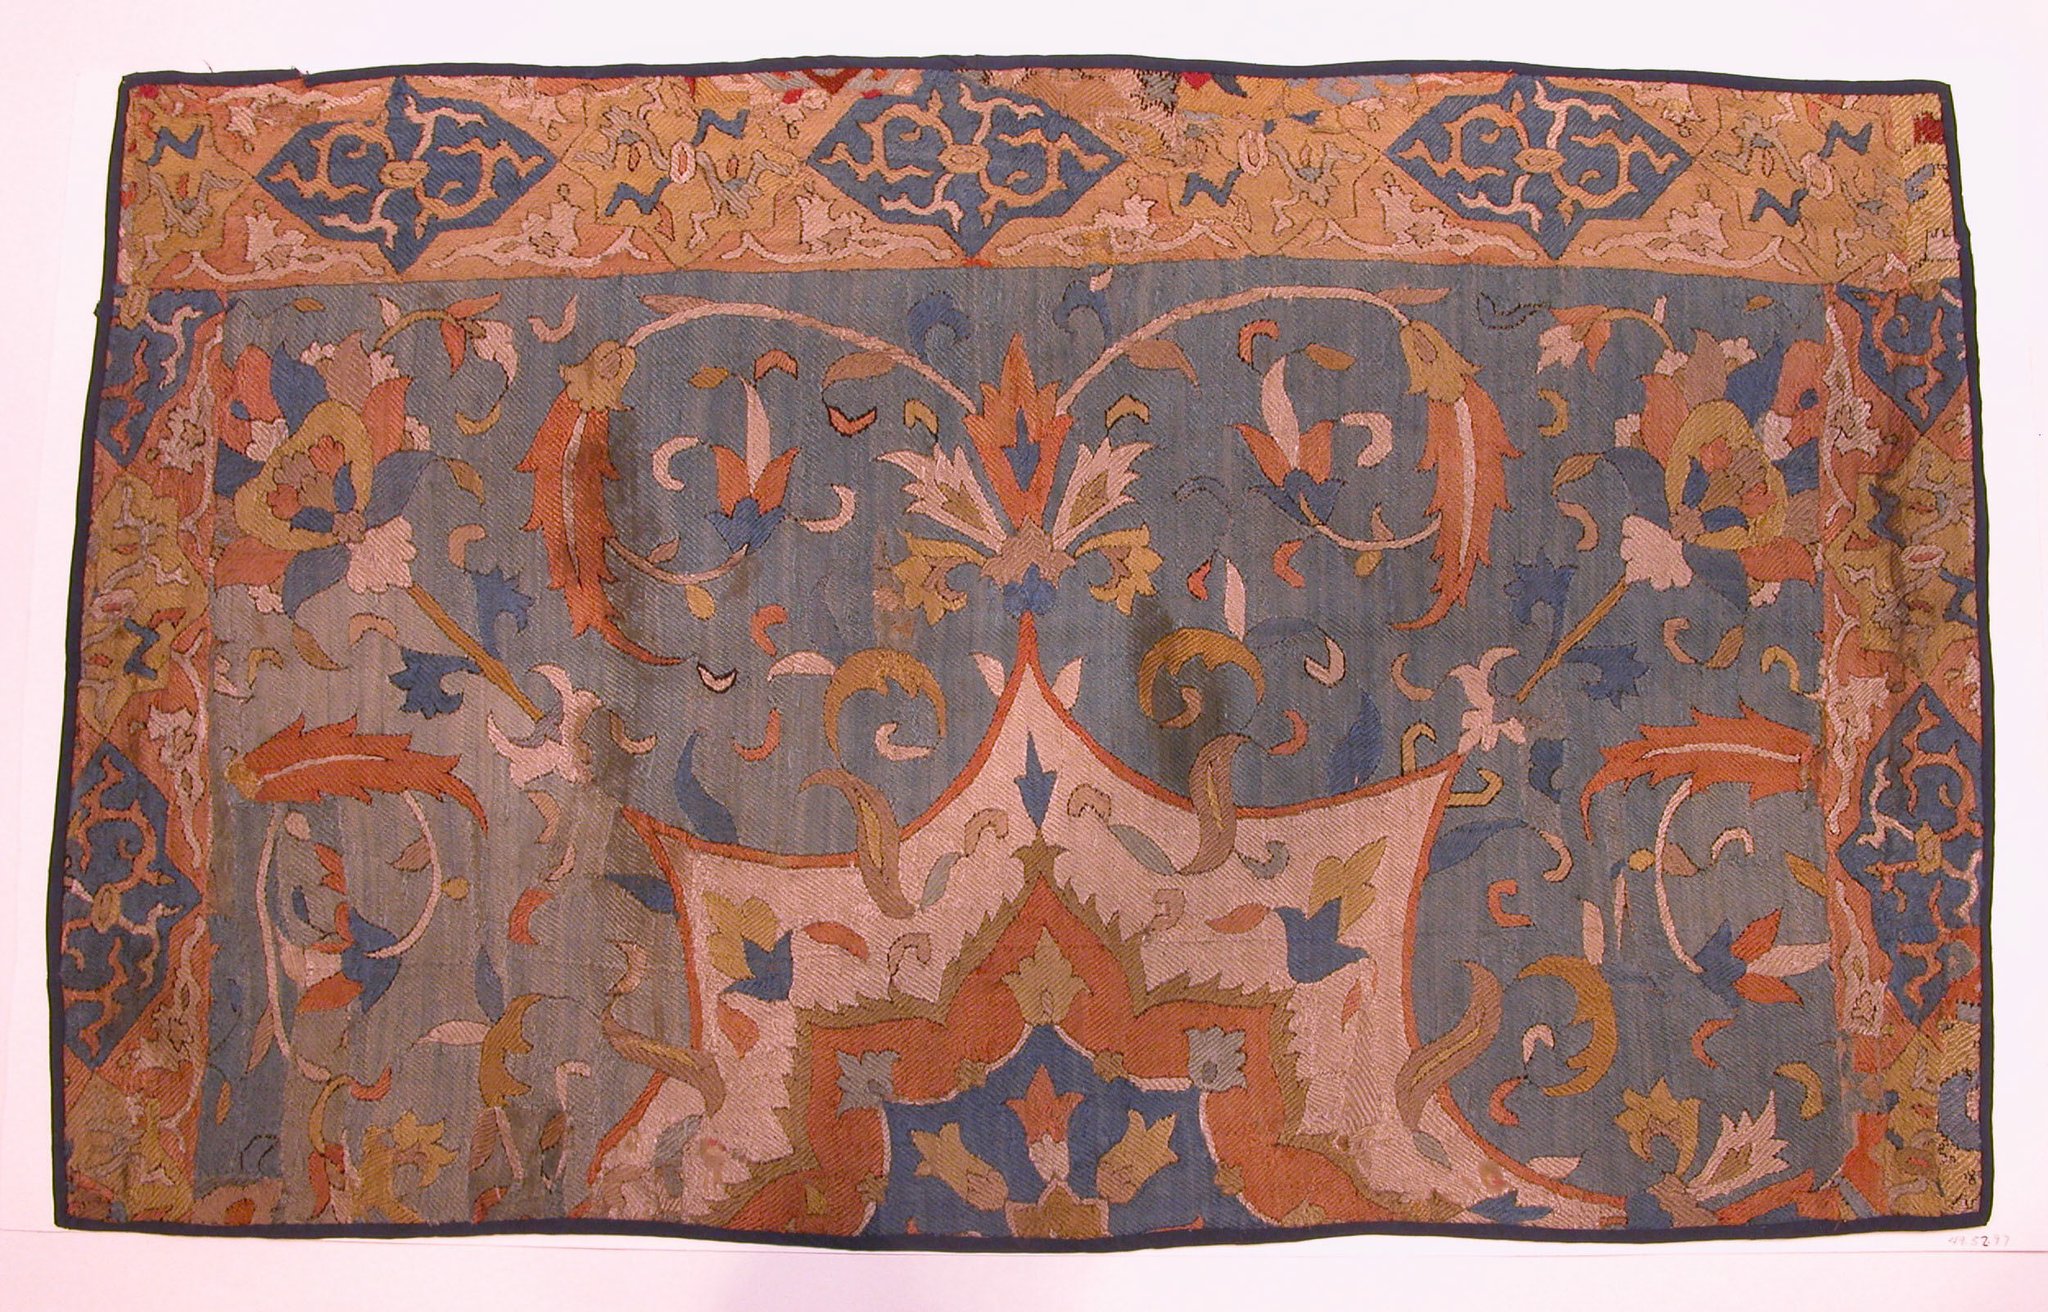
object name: textile fragment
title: Fragment of a Cover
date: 1701-1800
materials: linen, silk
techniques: embroidery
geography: iran